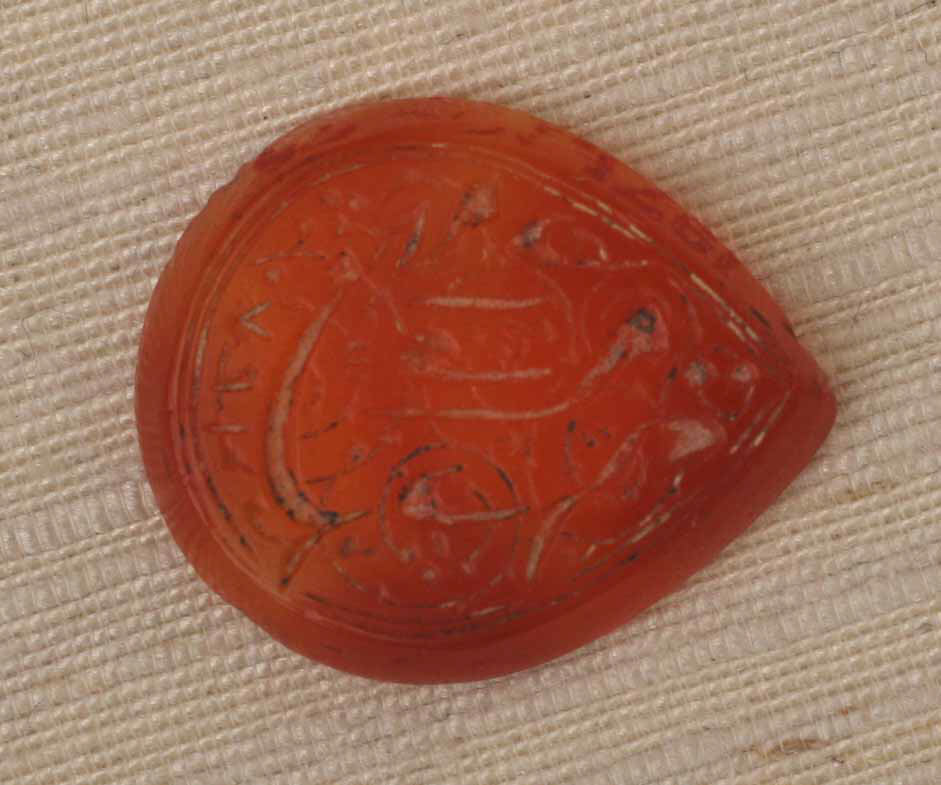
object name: stamp seal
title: Seal Stamp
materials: stone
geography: iran